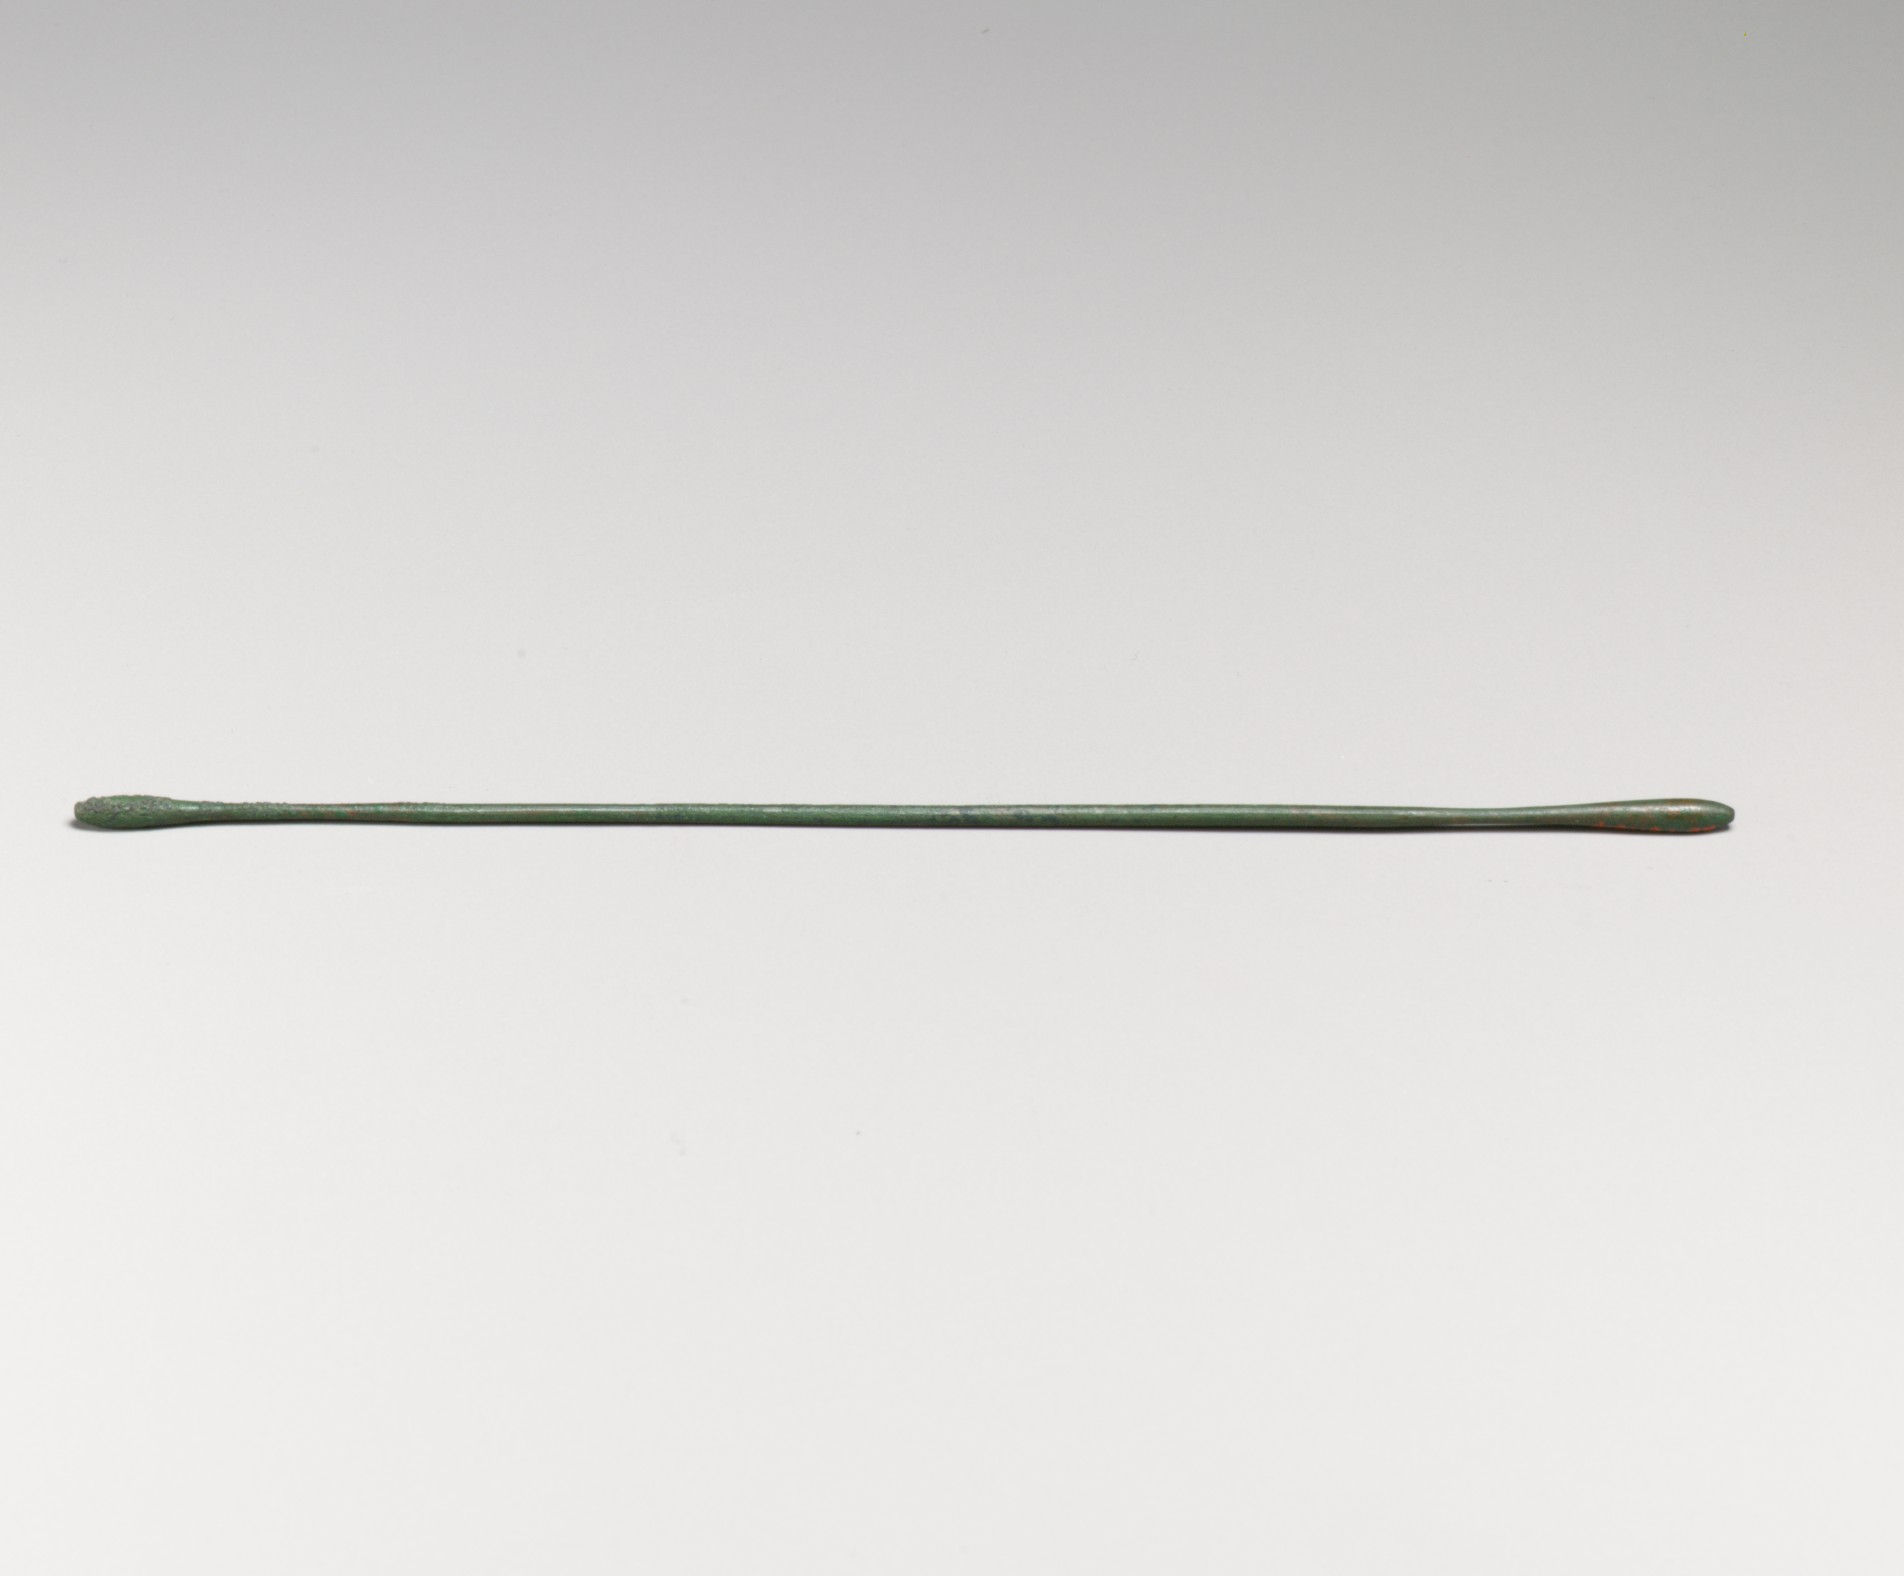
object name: probe, double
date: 7000 BCE-330 CE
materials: bronze